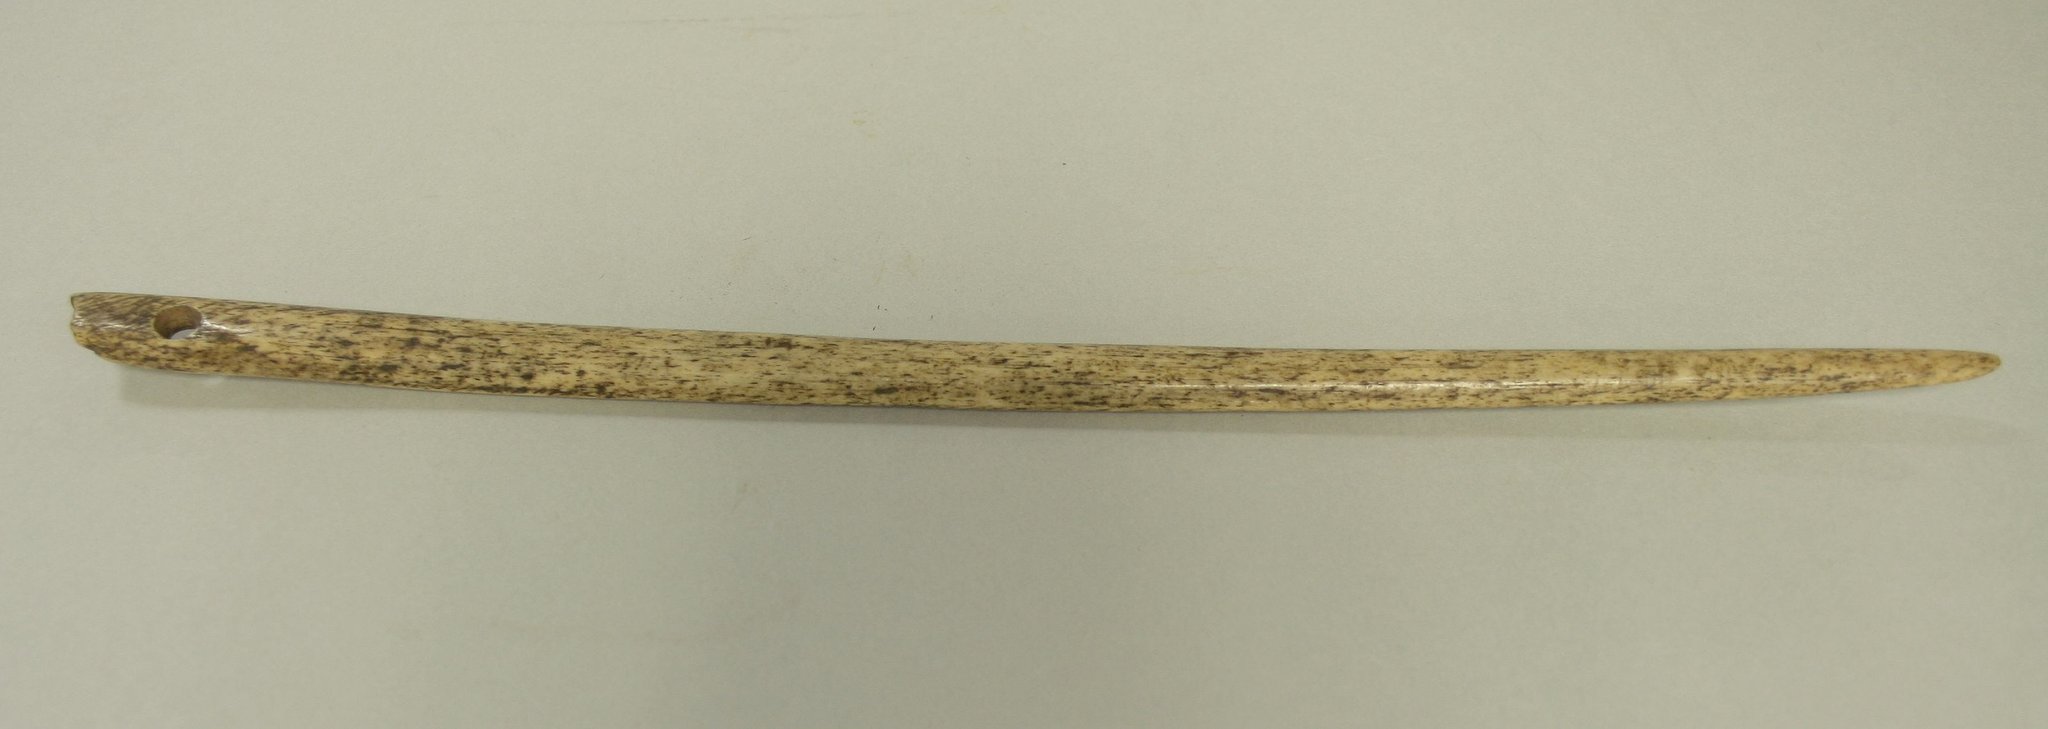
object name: awl punch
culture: tierra del fuego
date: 301-1600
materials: ivory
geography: argentina